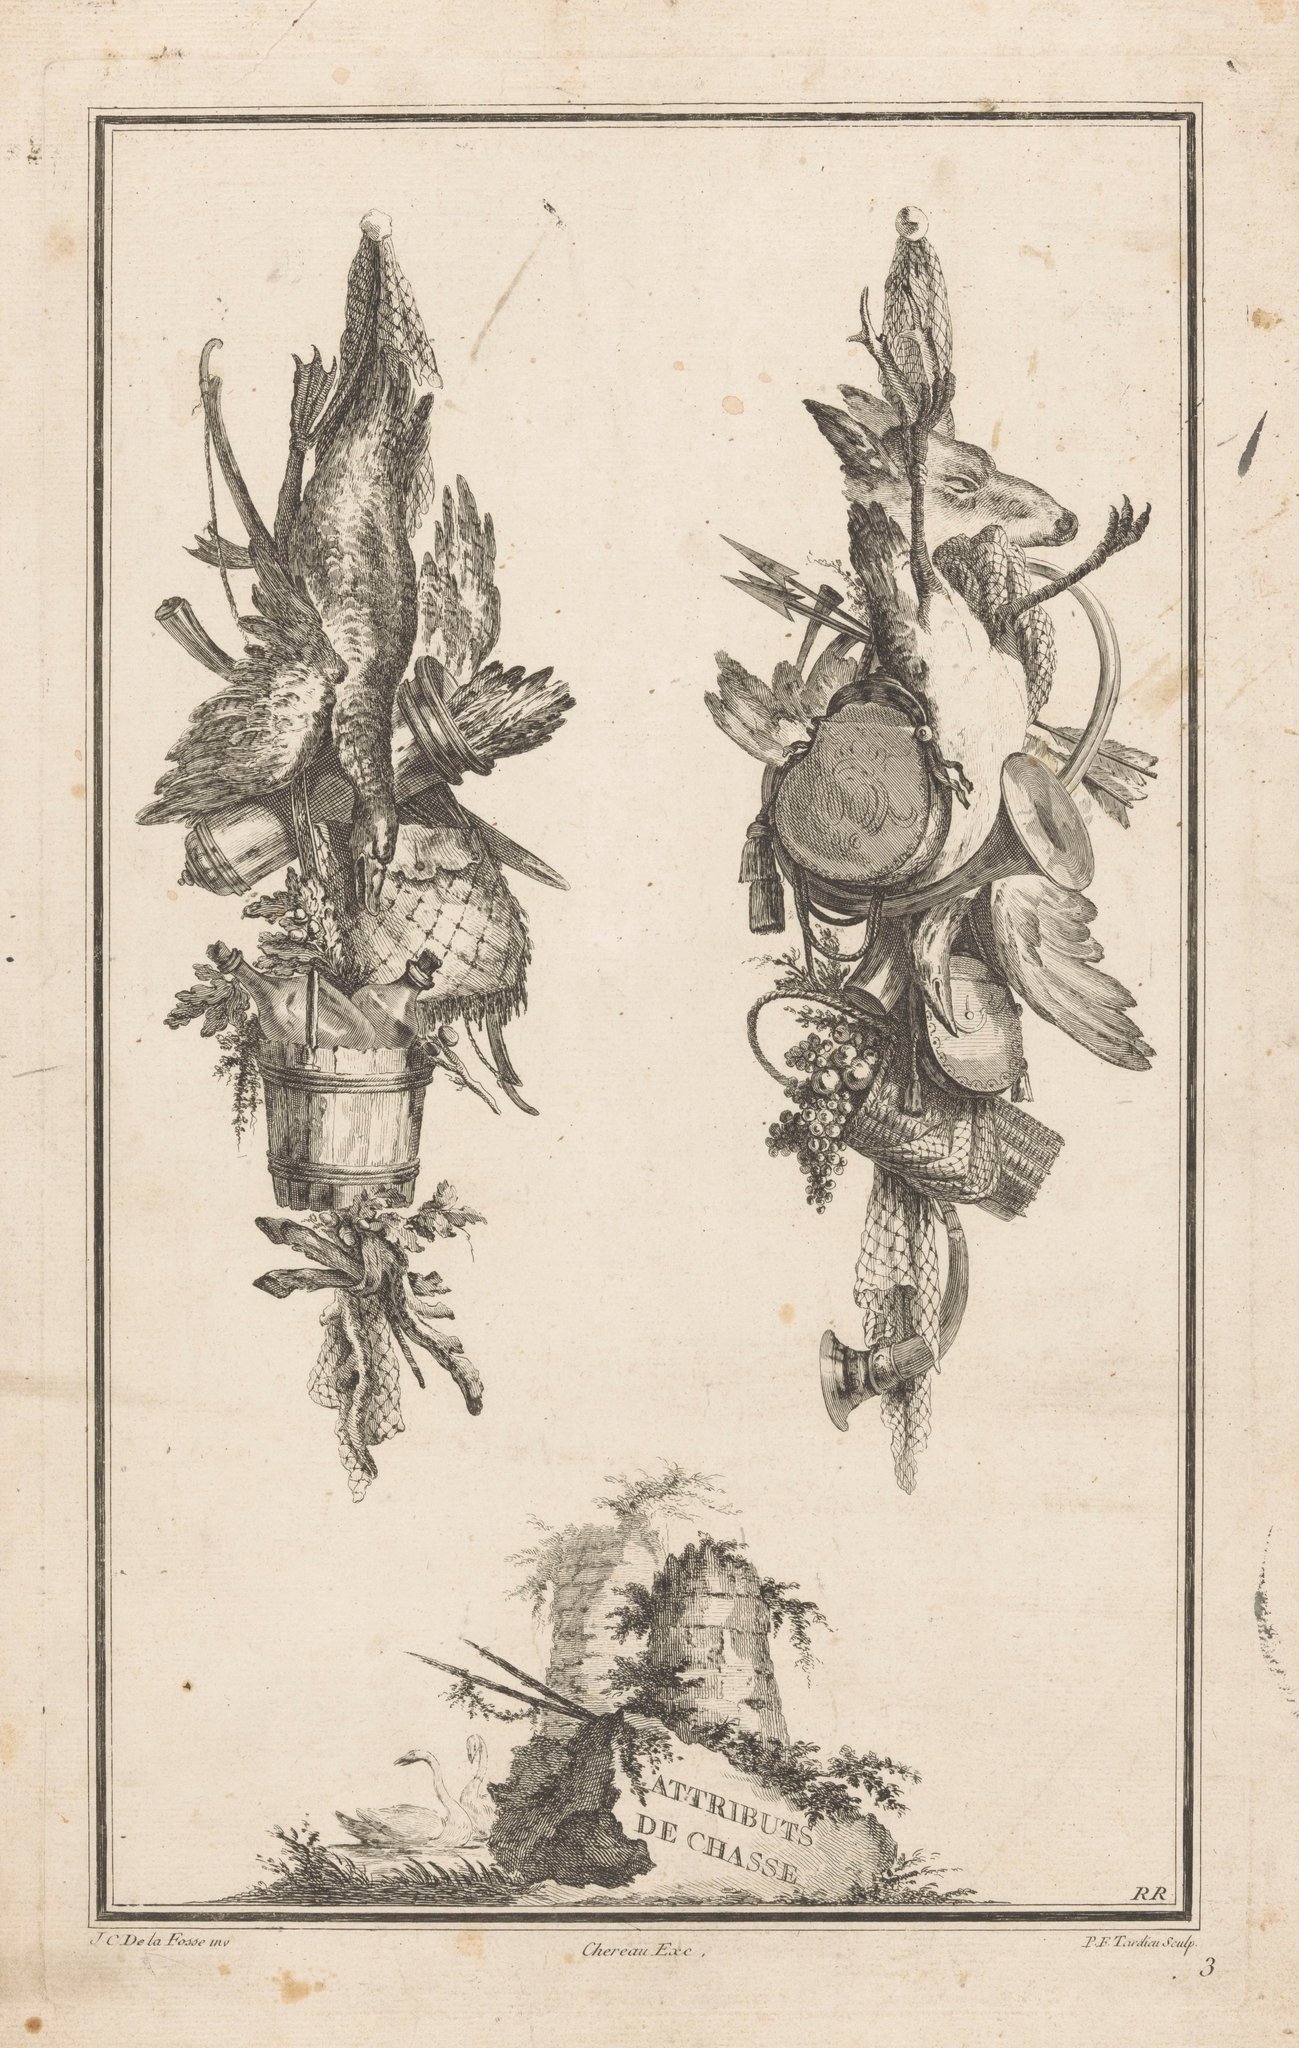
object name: ornament print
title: Trofeeën met eend en vogel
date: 1771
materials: paper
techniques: engraving, etching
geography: paris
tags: trophy, i.e.: decorative arrangement of symbolic or typical objects ~ ornament, hunting, chase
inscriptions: collector's mark: Lugt 2228, collector's mark: Lugt 2760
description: Links een trofee met een geschoten eend, een pijlenkoker, een tas en een vat met flessen. Rechts een trofee met een hertenkop, een geschoten vogel, een jachthoorn en een mand met fruit.